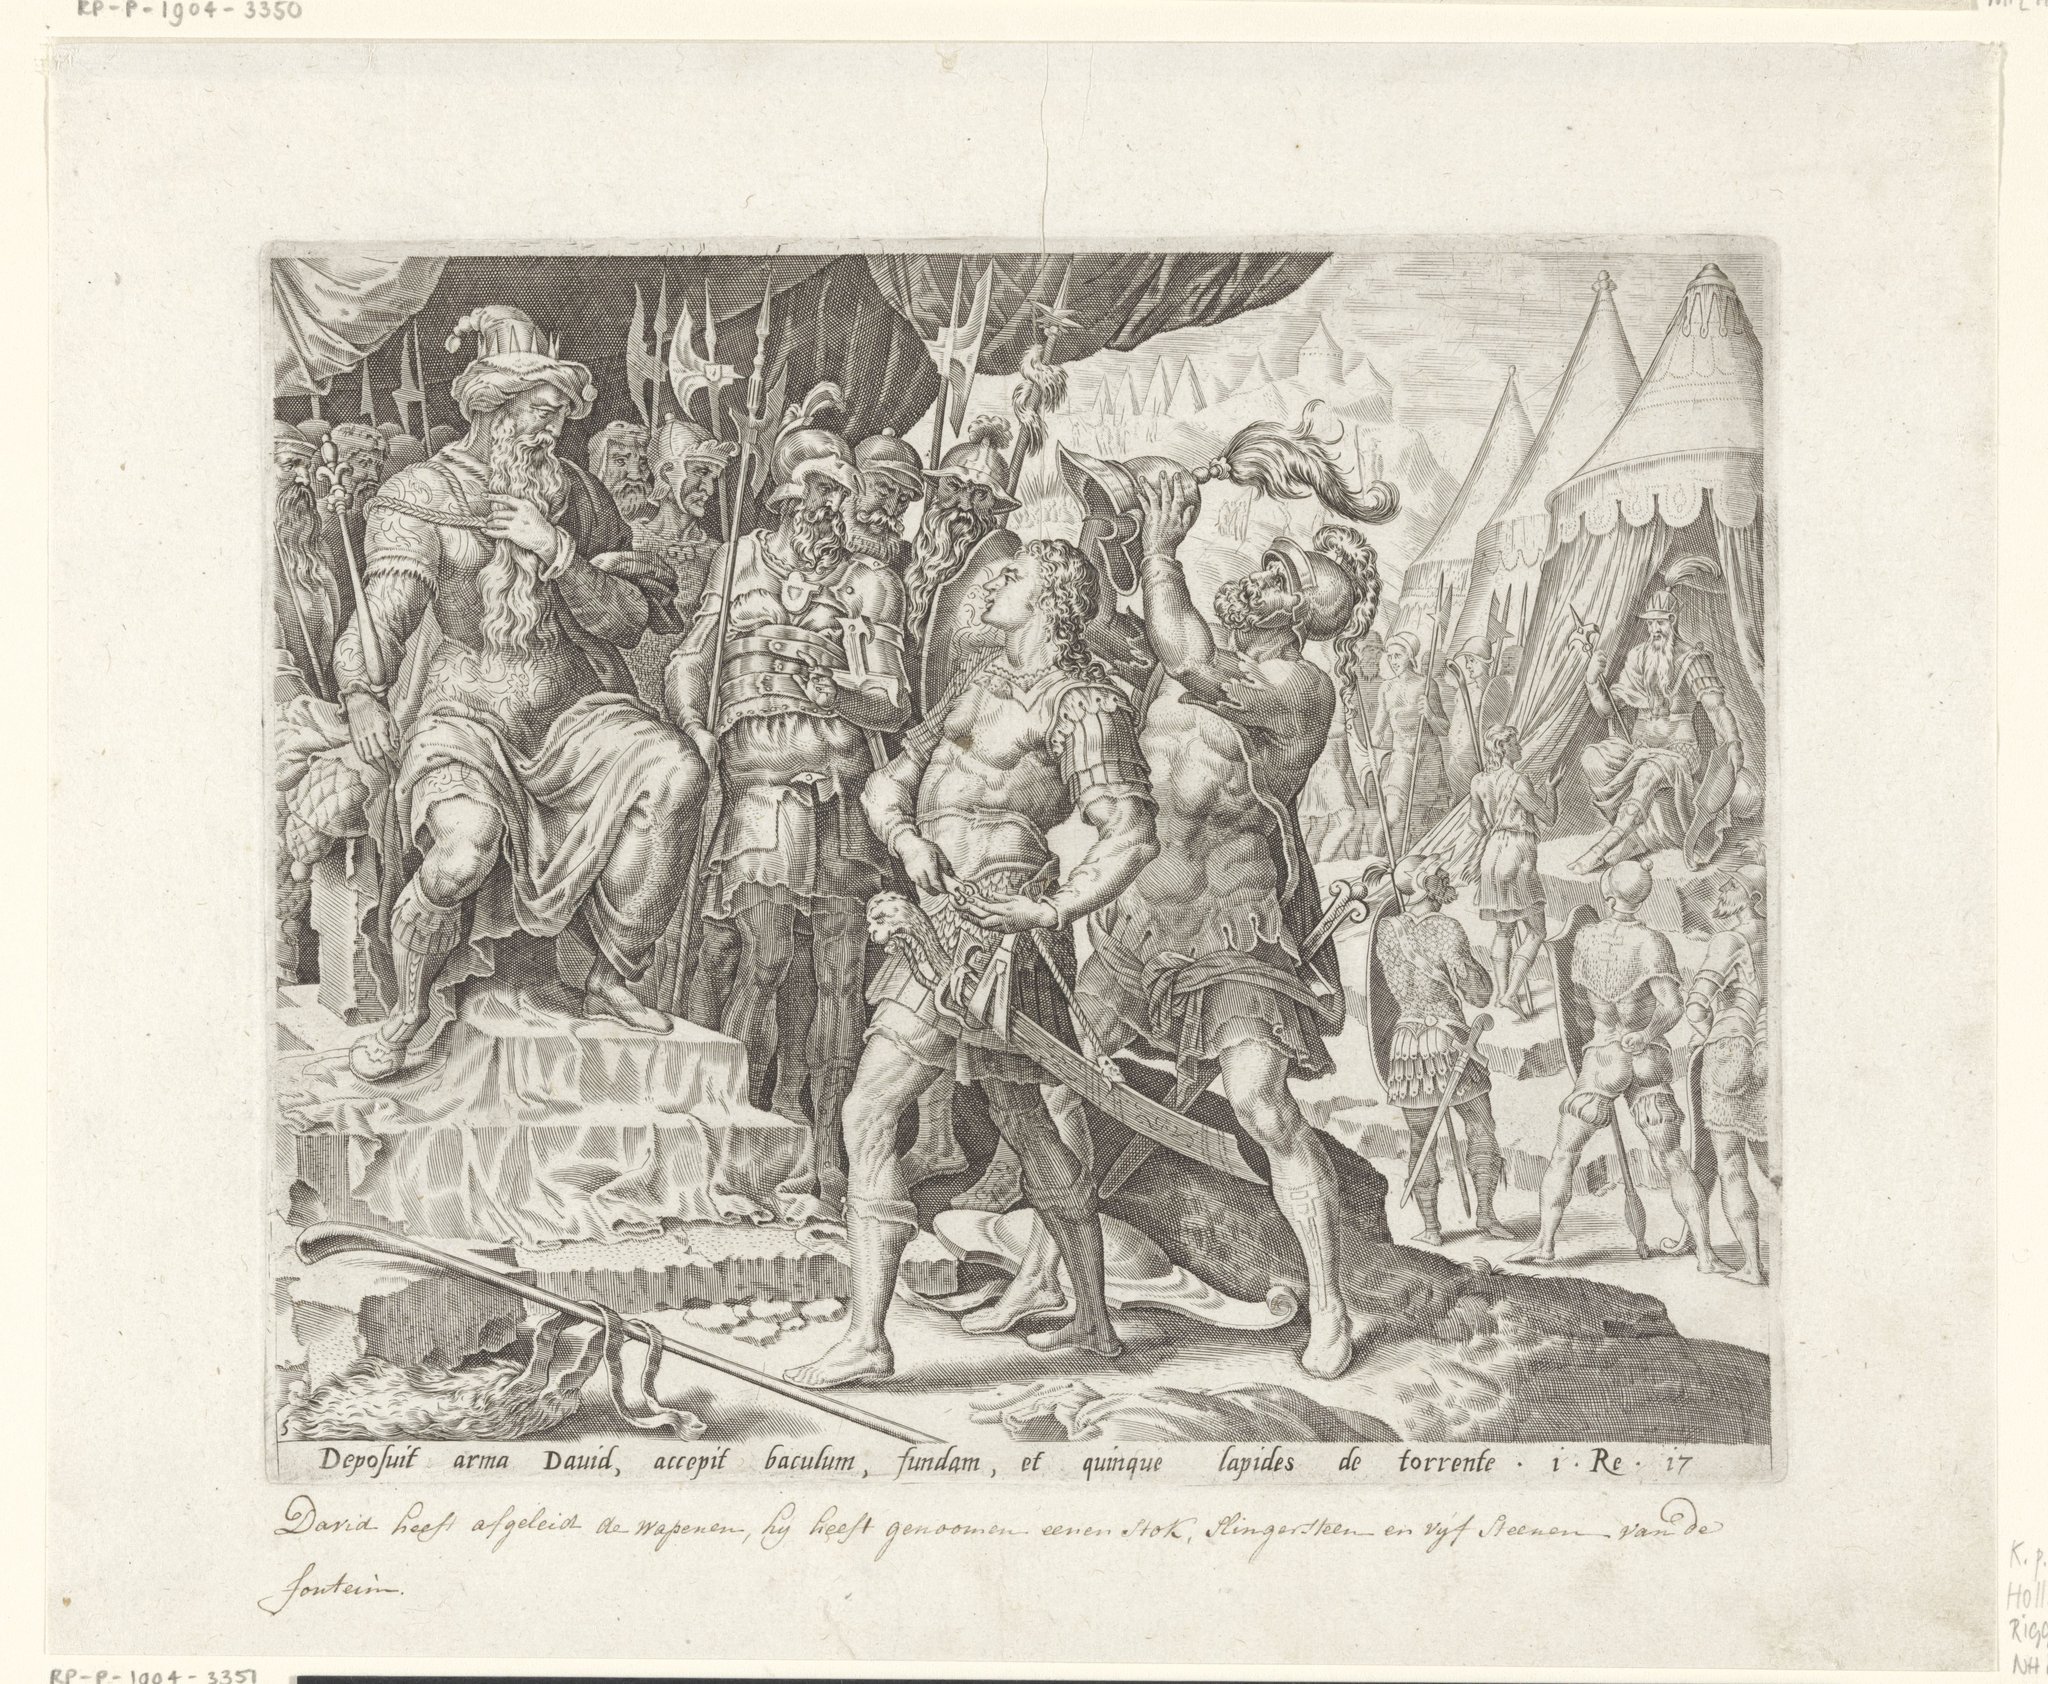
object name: print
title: David ontvangt de wapenrusting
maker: Anonymous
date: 1555-1633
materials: paper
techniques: engraving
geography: low countries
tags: david receives saul's armour ~ story of david and goliath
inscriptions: collector's mark: Lugt 2228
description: David wordt door Saul in het legerkamp ontvangen, waar hij vertelt dat hij de strijd wil aanbinden met Goliat. David is op de voorgrond ten onrechte gedeeltelijk in wapenrusting afgebeeld, omdat hij de uitrusting weigerde. De soldaat achter hem zet een helm op zijn hoofd. In de marge een éénregelig onderschrift in het Latijn uit 1 Sam. (foutief aangeduid als 1 Koningen op de prent).